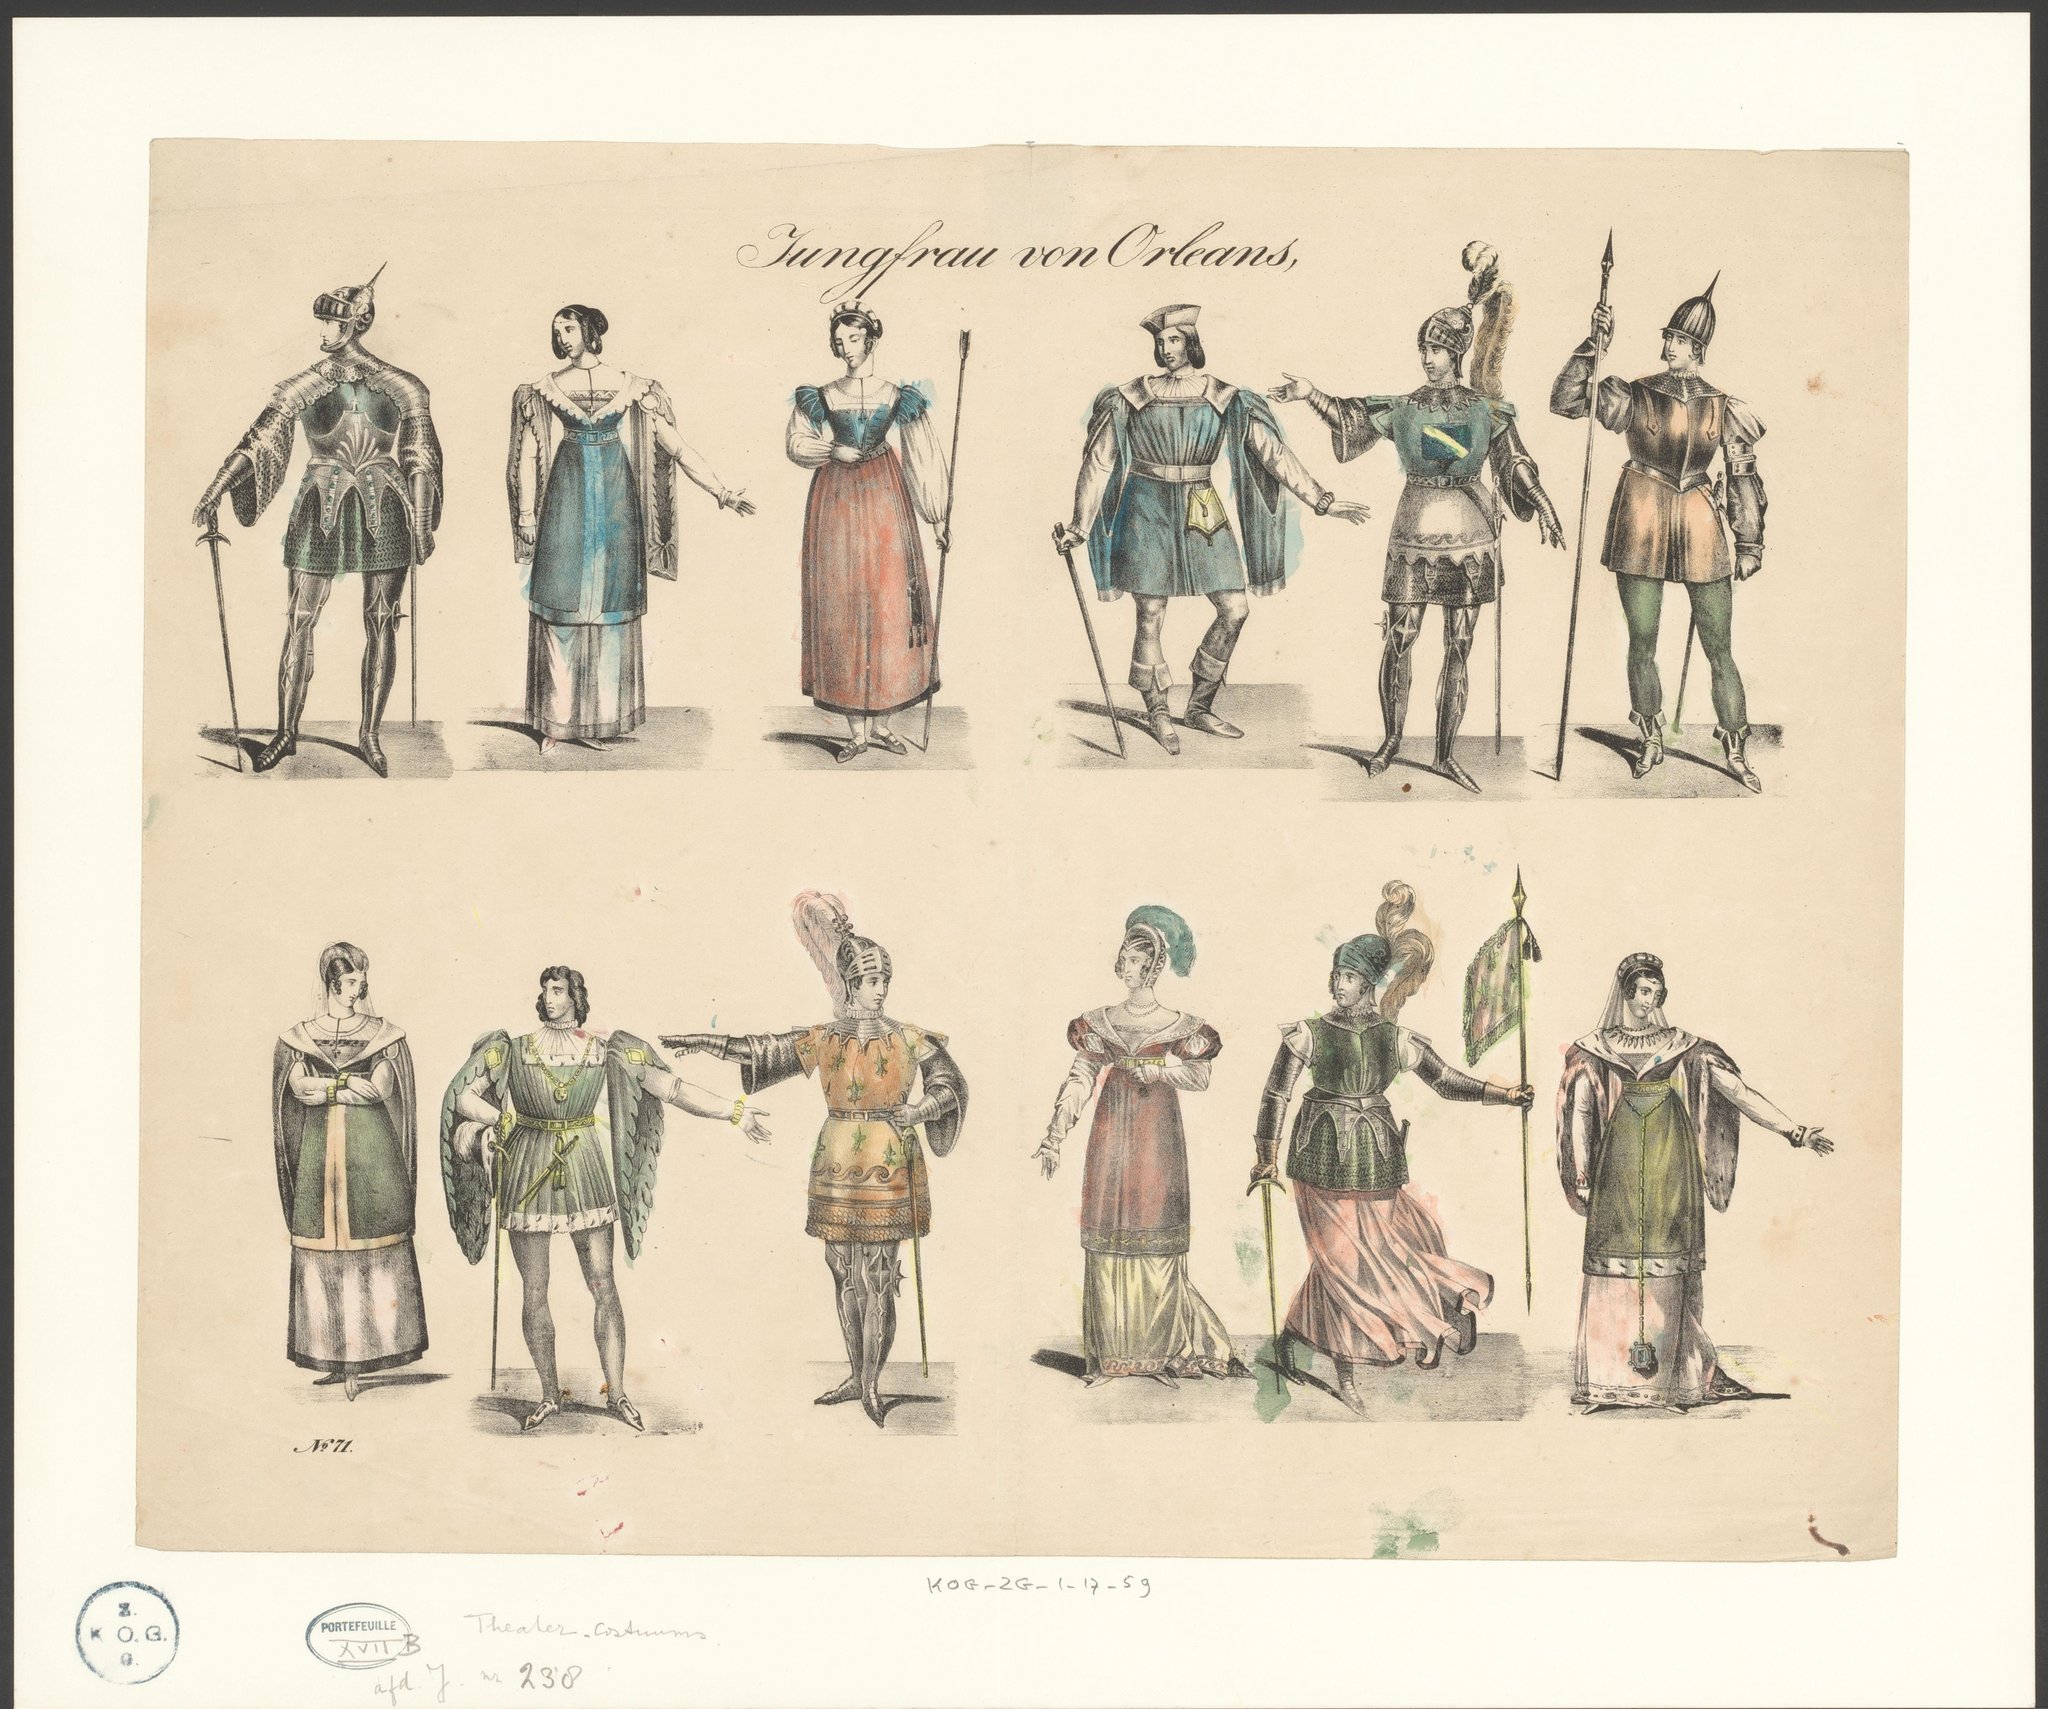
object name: popular print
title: Personages uit het toneelstuk Jungfrau von Orleans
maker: Anonymous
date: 1801-1849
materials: paper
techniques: hand coloring, lithograph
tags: theatre, theatrical performance, characters (human types)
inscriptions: stamp, collector's mark: Lugt 1641, inscription: ‘32:65’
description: Blad met zes personages uit het toneelstuk Jungfrau von Orleans. Linksonder genummerd: No. 71. Onderwerpsrubrieken binnen de Atlas Zeden en Gewoonten: Tooneel, Scènes en figuren uit bekende toneelspellen.